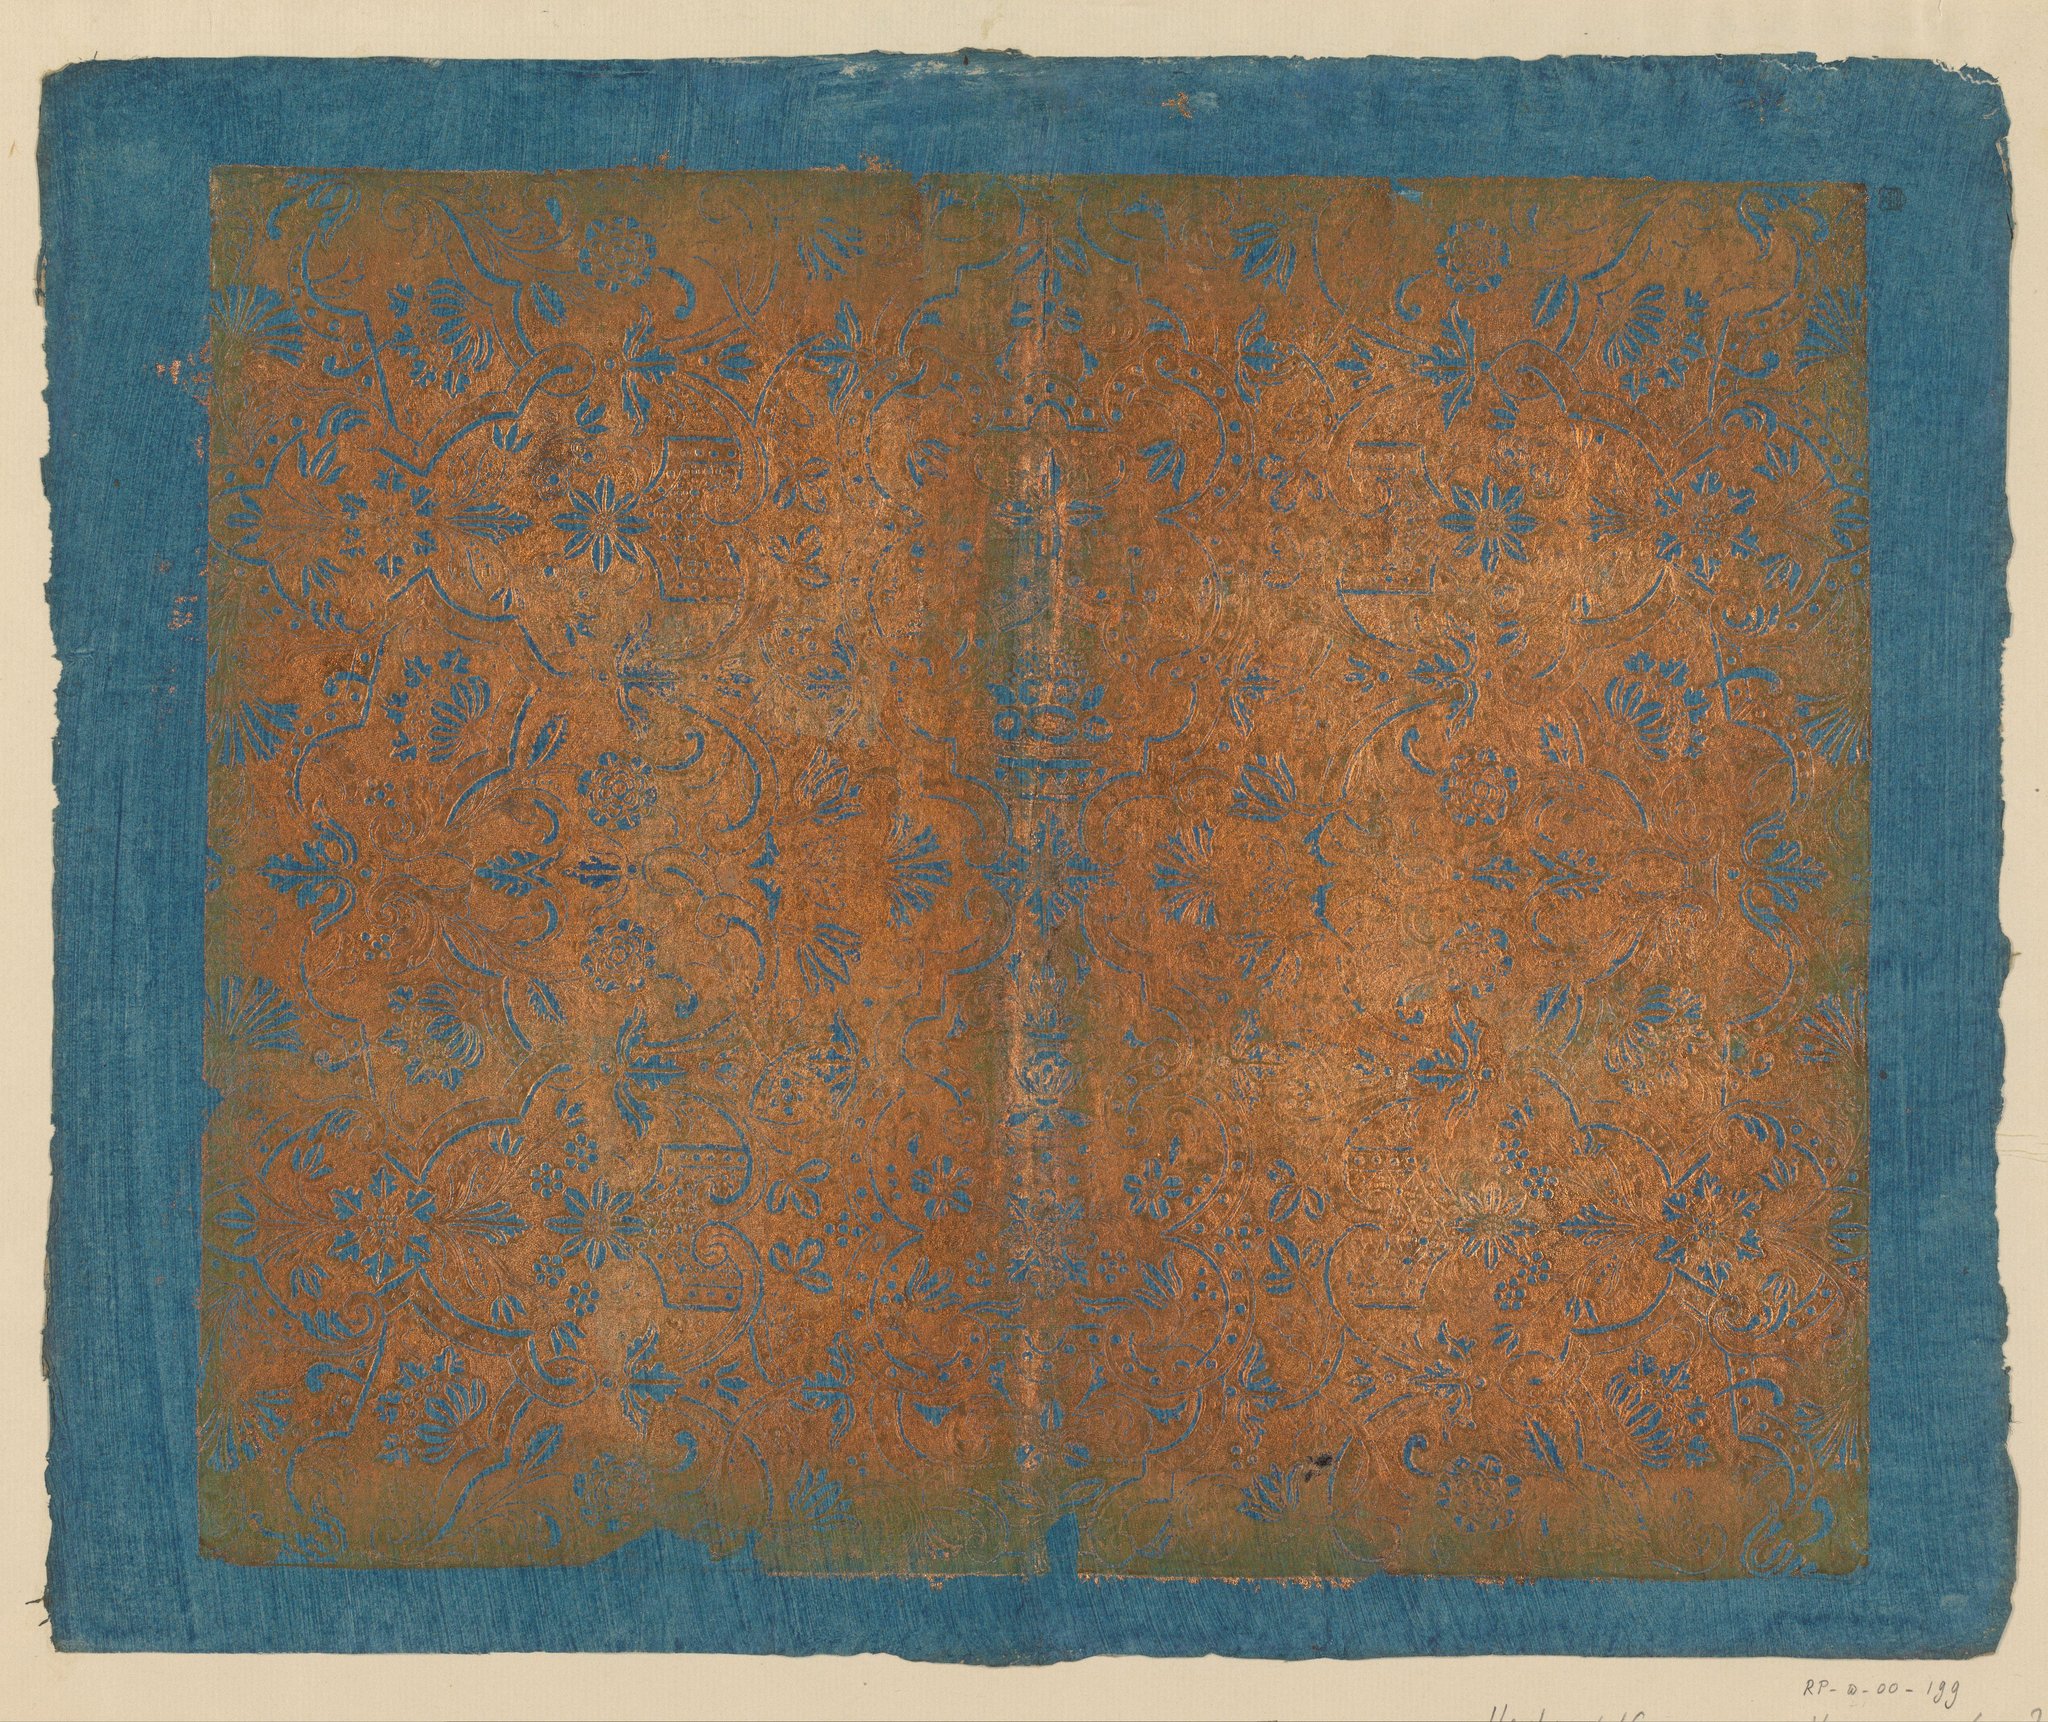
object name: brocade paper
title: Blad met Lodewijk XIV-ornament, ranken met bloemen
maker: Anonymous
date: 1780-1820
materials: gold leaf, paint, paper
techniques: relief print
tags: ornament derived from plant forms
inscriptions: collector's mark: Lugt 2760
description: Blad met Lodewijk XIV-ornament, ranken met bloemen. Twee identieke spiegelbeeldige helften.